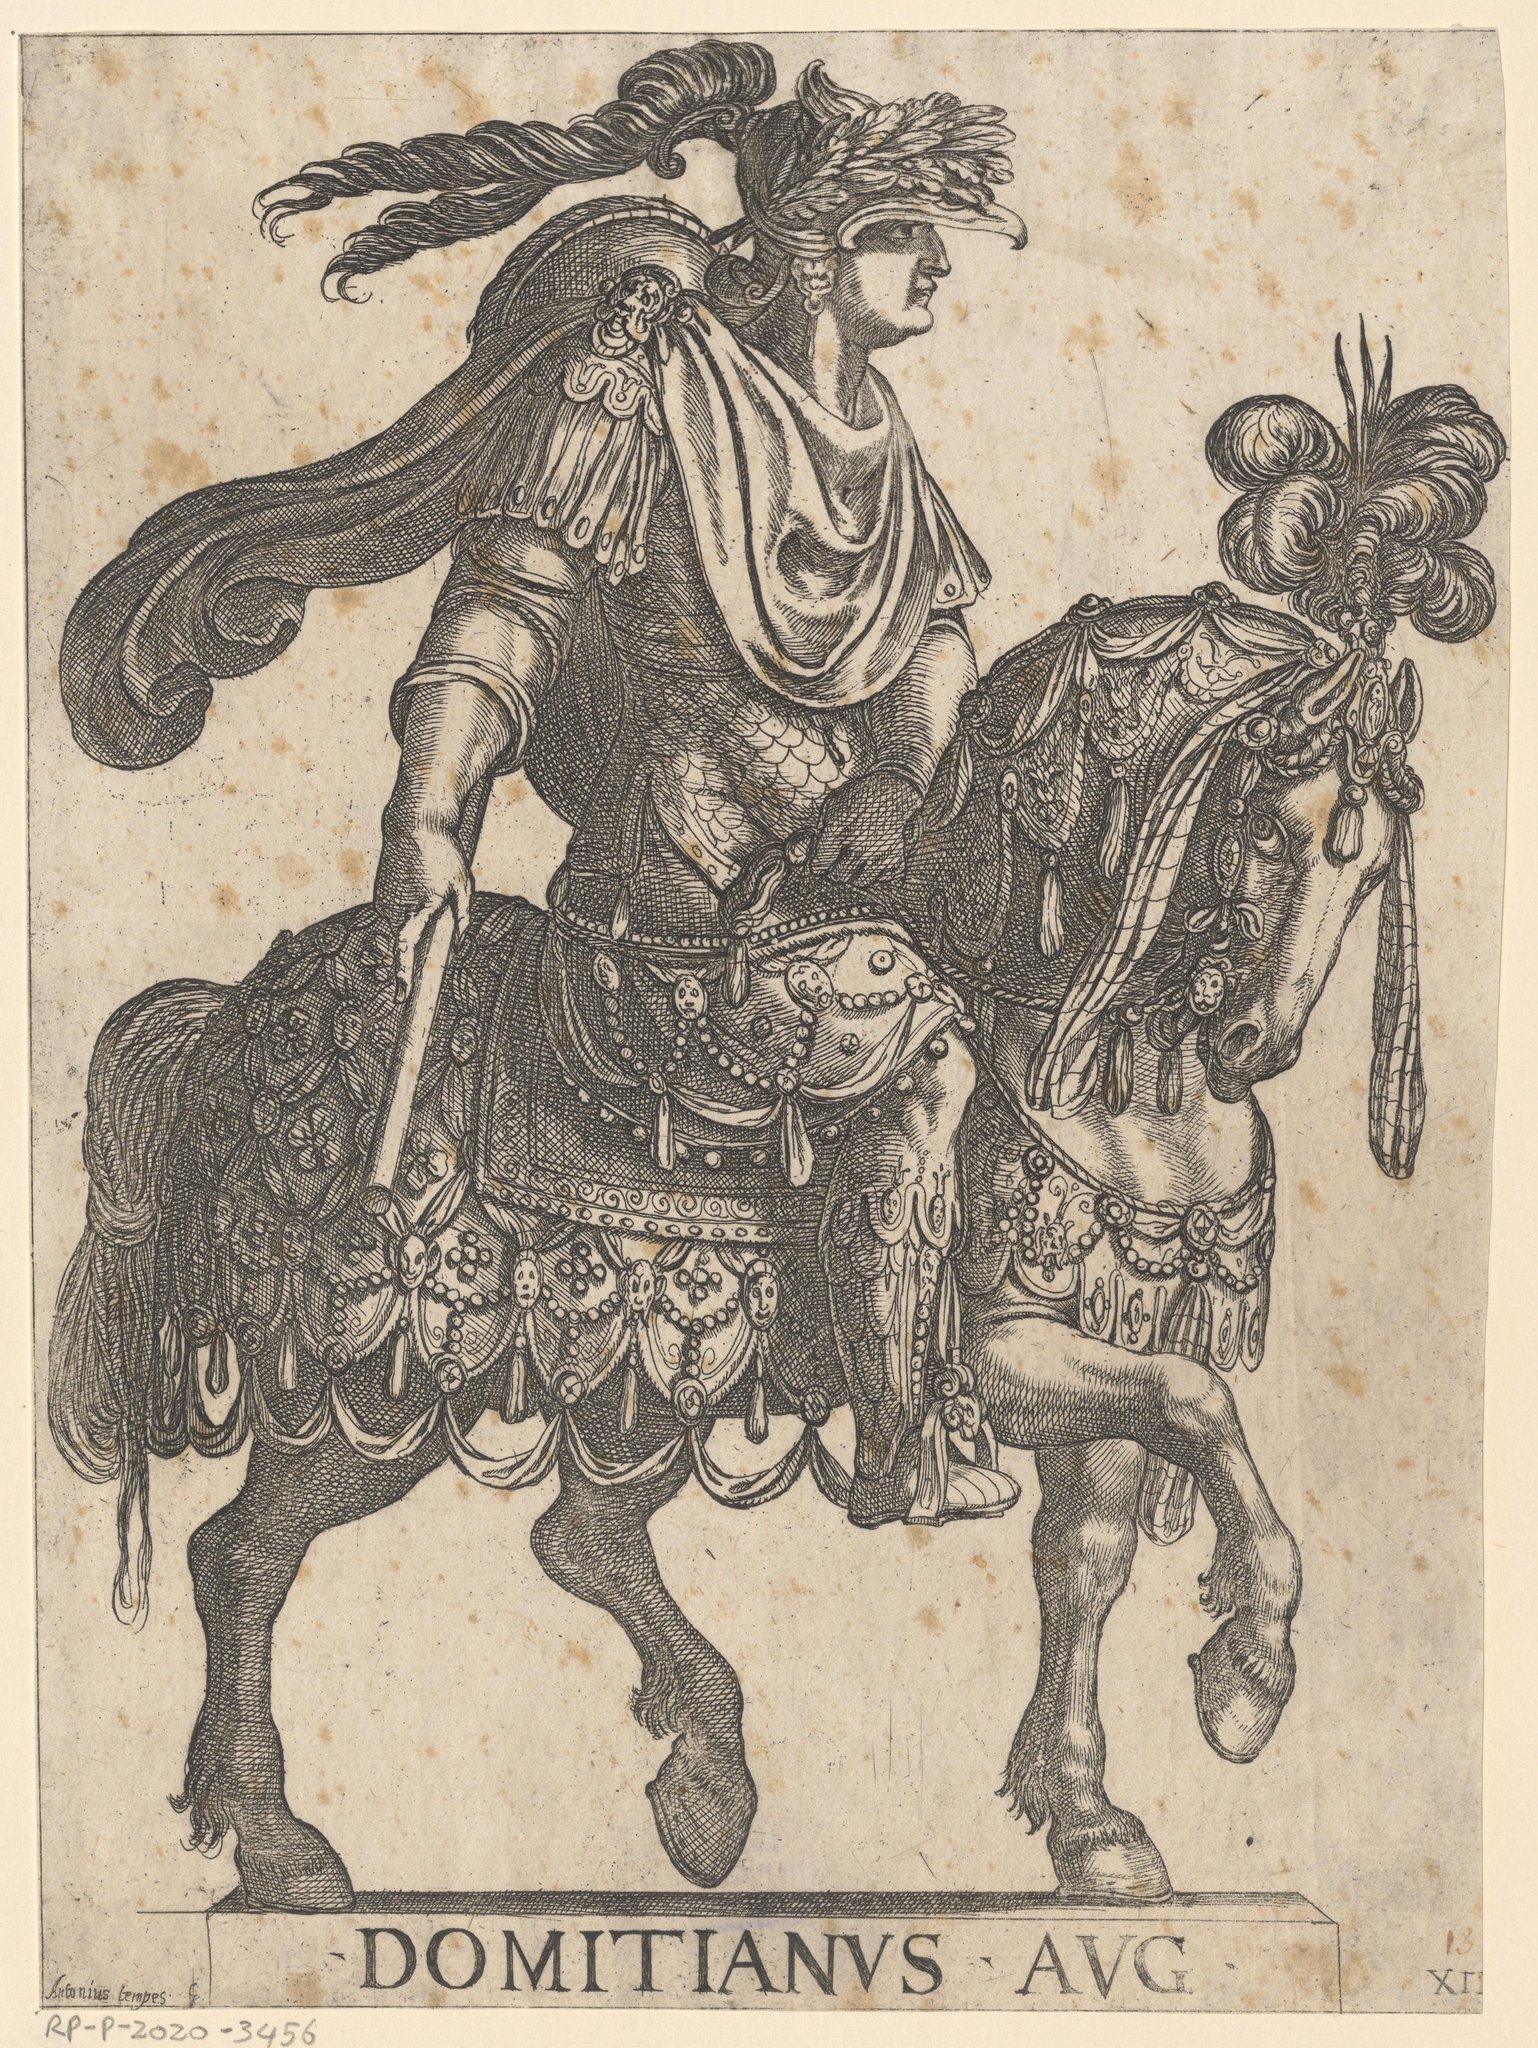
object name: print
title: XII caesares in equestri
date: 1596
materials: paper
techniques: etching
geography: rome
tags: historical persons, emperor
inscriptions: inscription: ‘13’